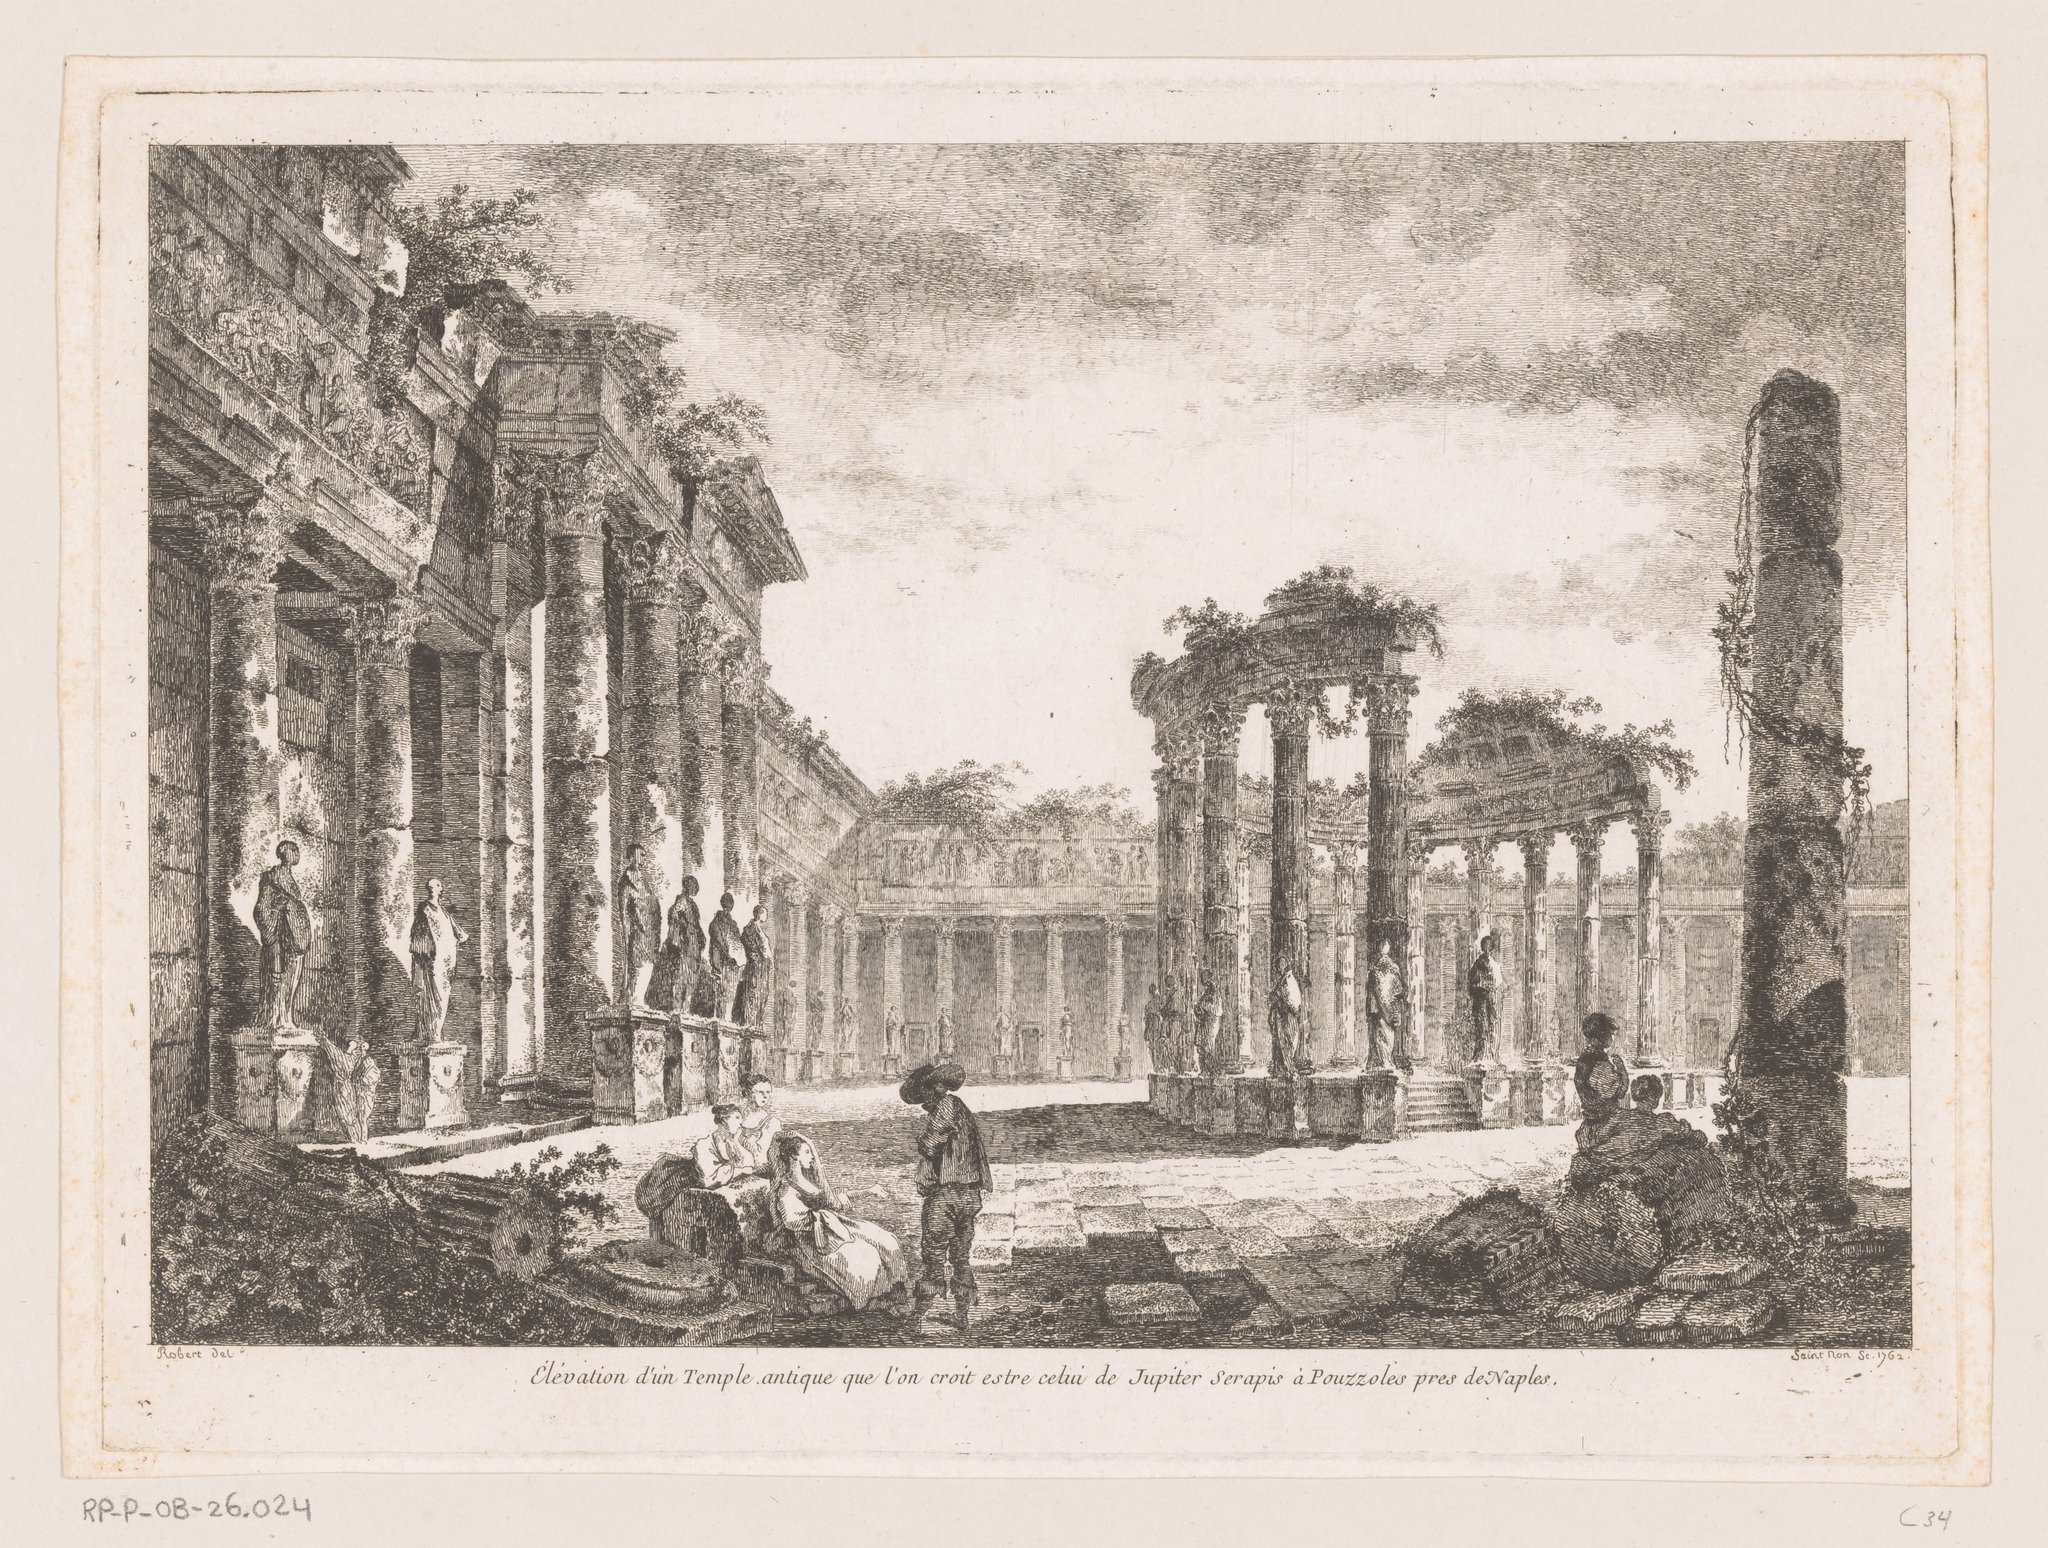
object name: print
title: Élévation d'un Temple antique que l'on croit estre celui de Jupiter Serapis à Pouzzoles pres de Naples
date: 1762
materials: paper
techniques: etching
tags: city-view, and landscape with man-made constructions, temple, shrine ~ roman religion, pozzuoli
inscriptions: collector's mark: Lugt 240